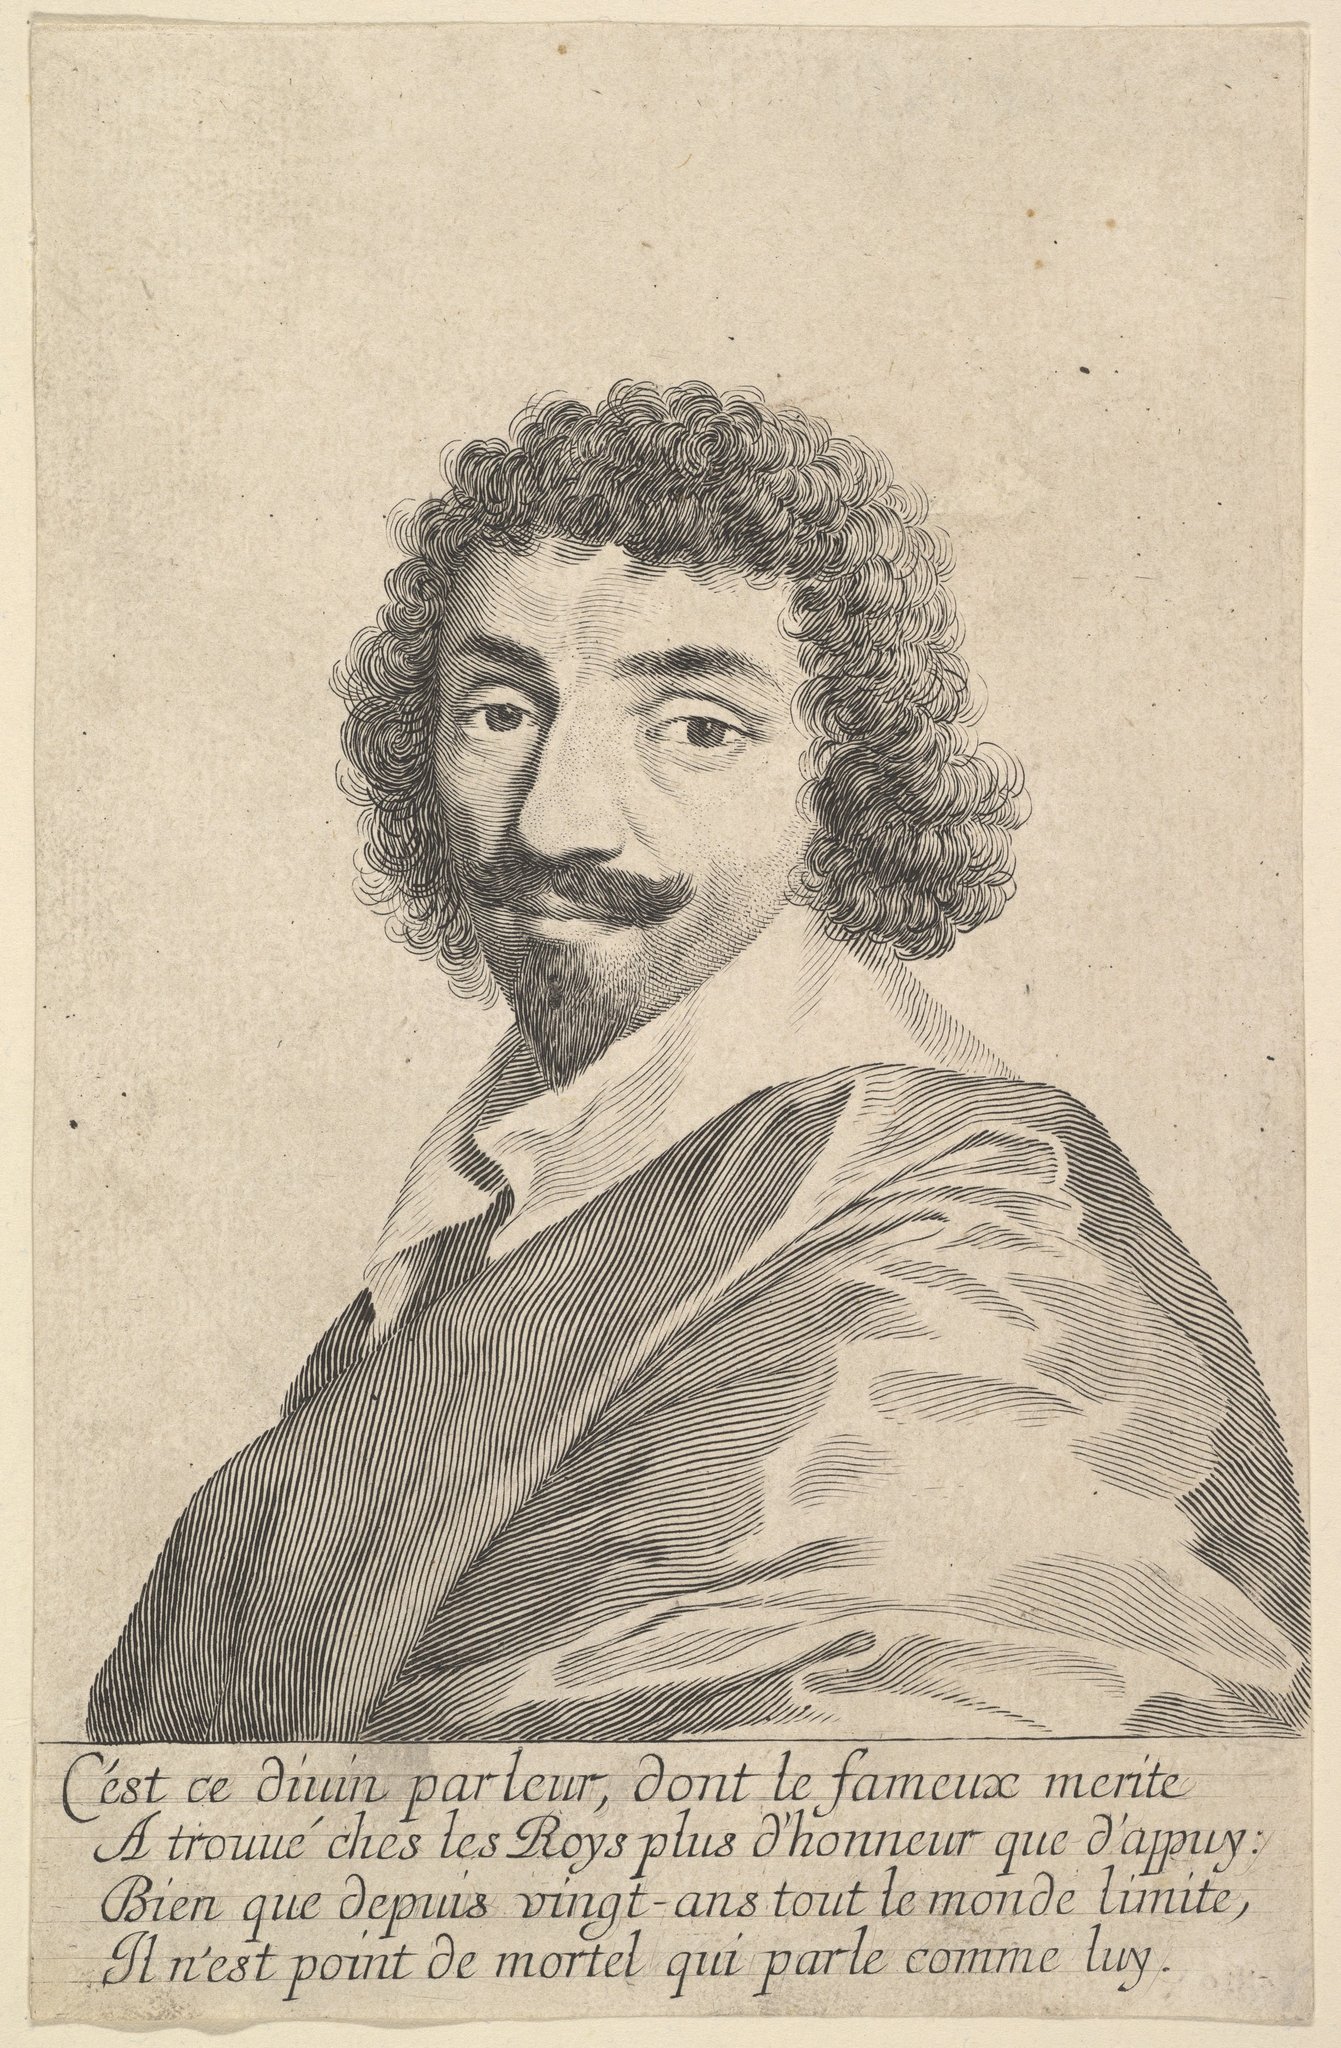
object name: print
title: Jean-Louis Guez de Balzac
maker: claude mellan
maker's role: artist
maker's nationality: french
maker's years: 1598-1688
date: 1635-1637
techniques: engraving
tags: men,portraits